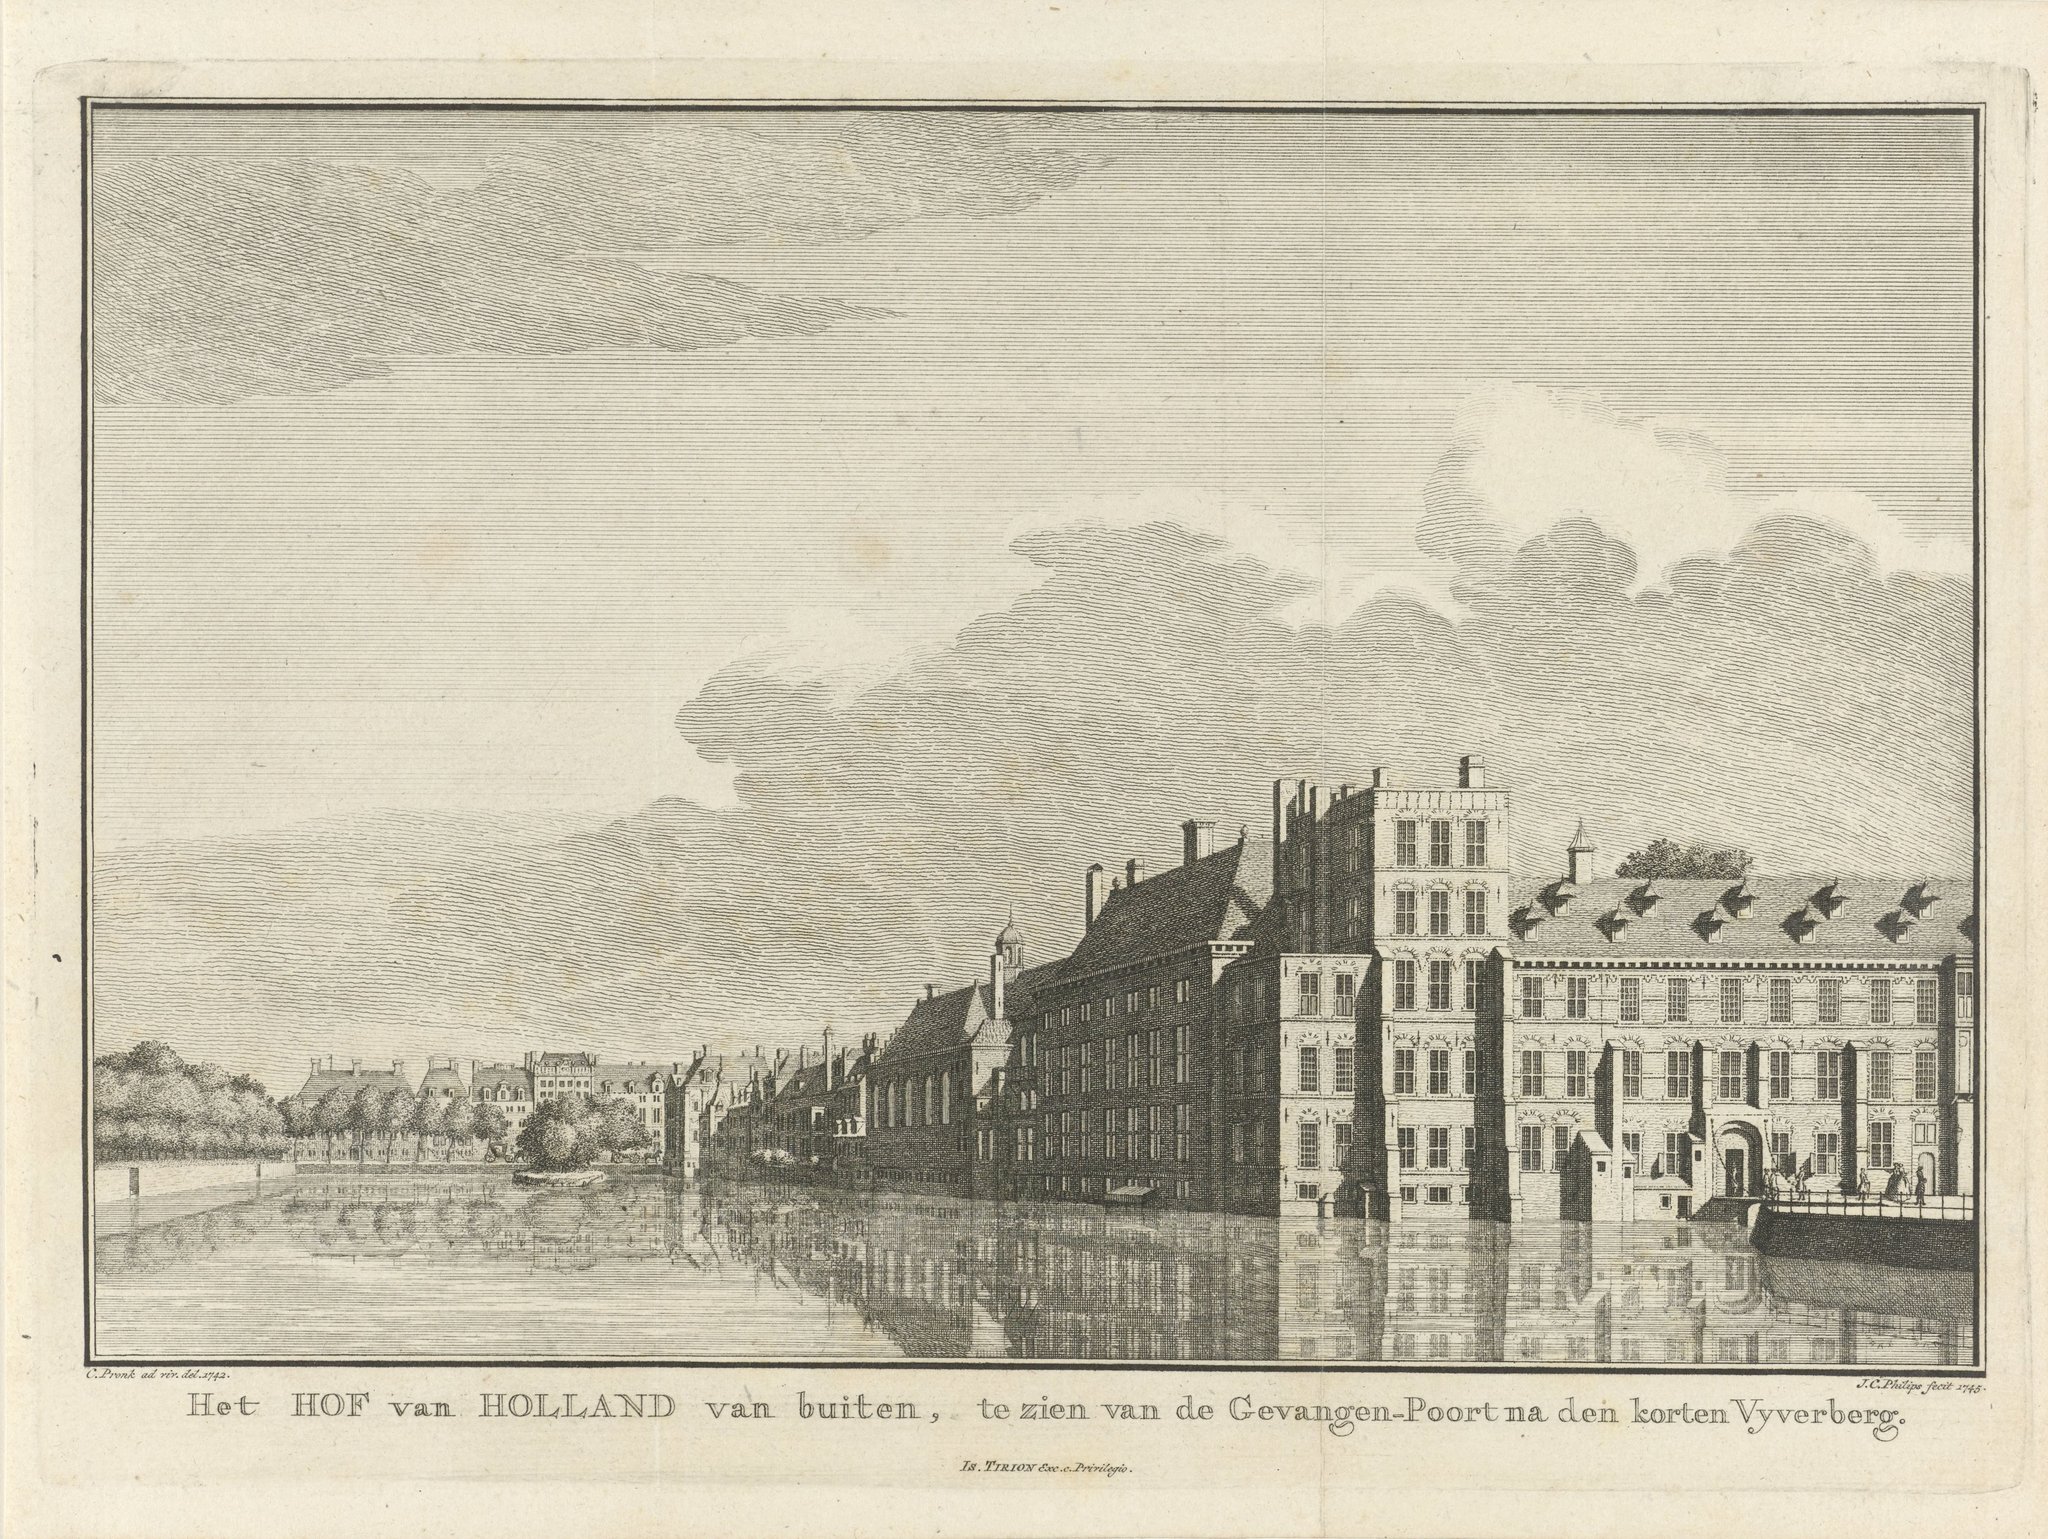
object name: print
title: Gezicht op het Hof van Holland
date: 1745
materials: paper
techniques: etching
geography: amsterdam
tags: binnenhof, hofvijver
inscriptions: collector's mark: Lugt 2228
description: Gezicht op het stadhouderlijk hof te Den Haag, met de gebouwen van het Binnenhof en de huizen aan de Korte Vijverberg.